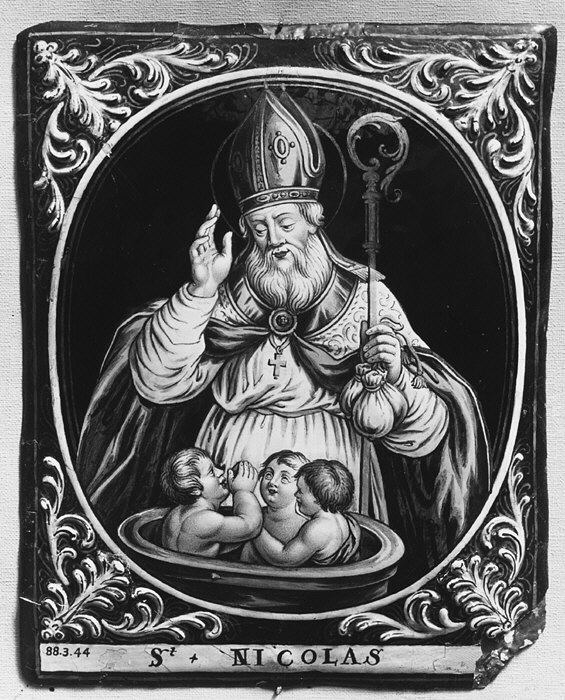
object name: plaque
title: Saint Nicolas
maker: jacques ii laudin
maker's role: enameler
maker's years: 1658-1734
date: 1667-1733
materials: copper, enamel, gilt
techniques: painting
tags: children,saints